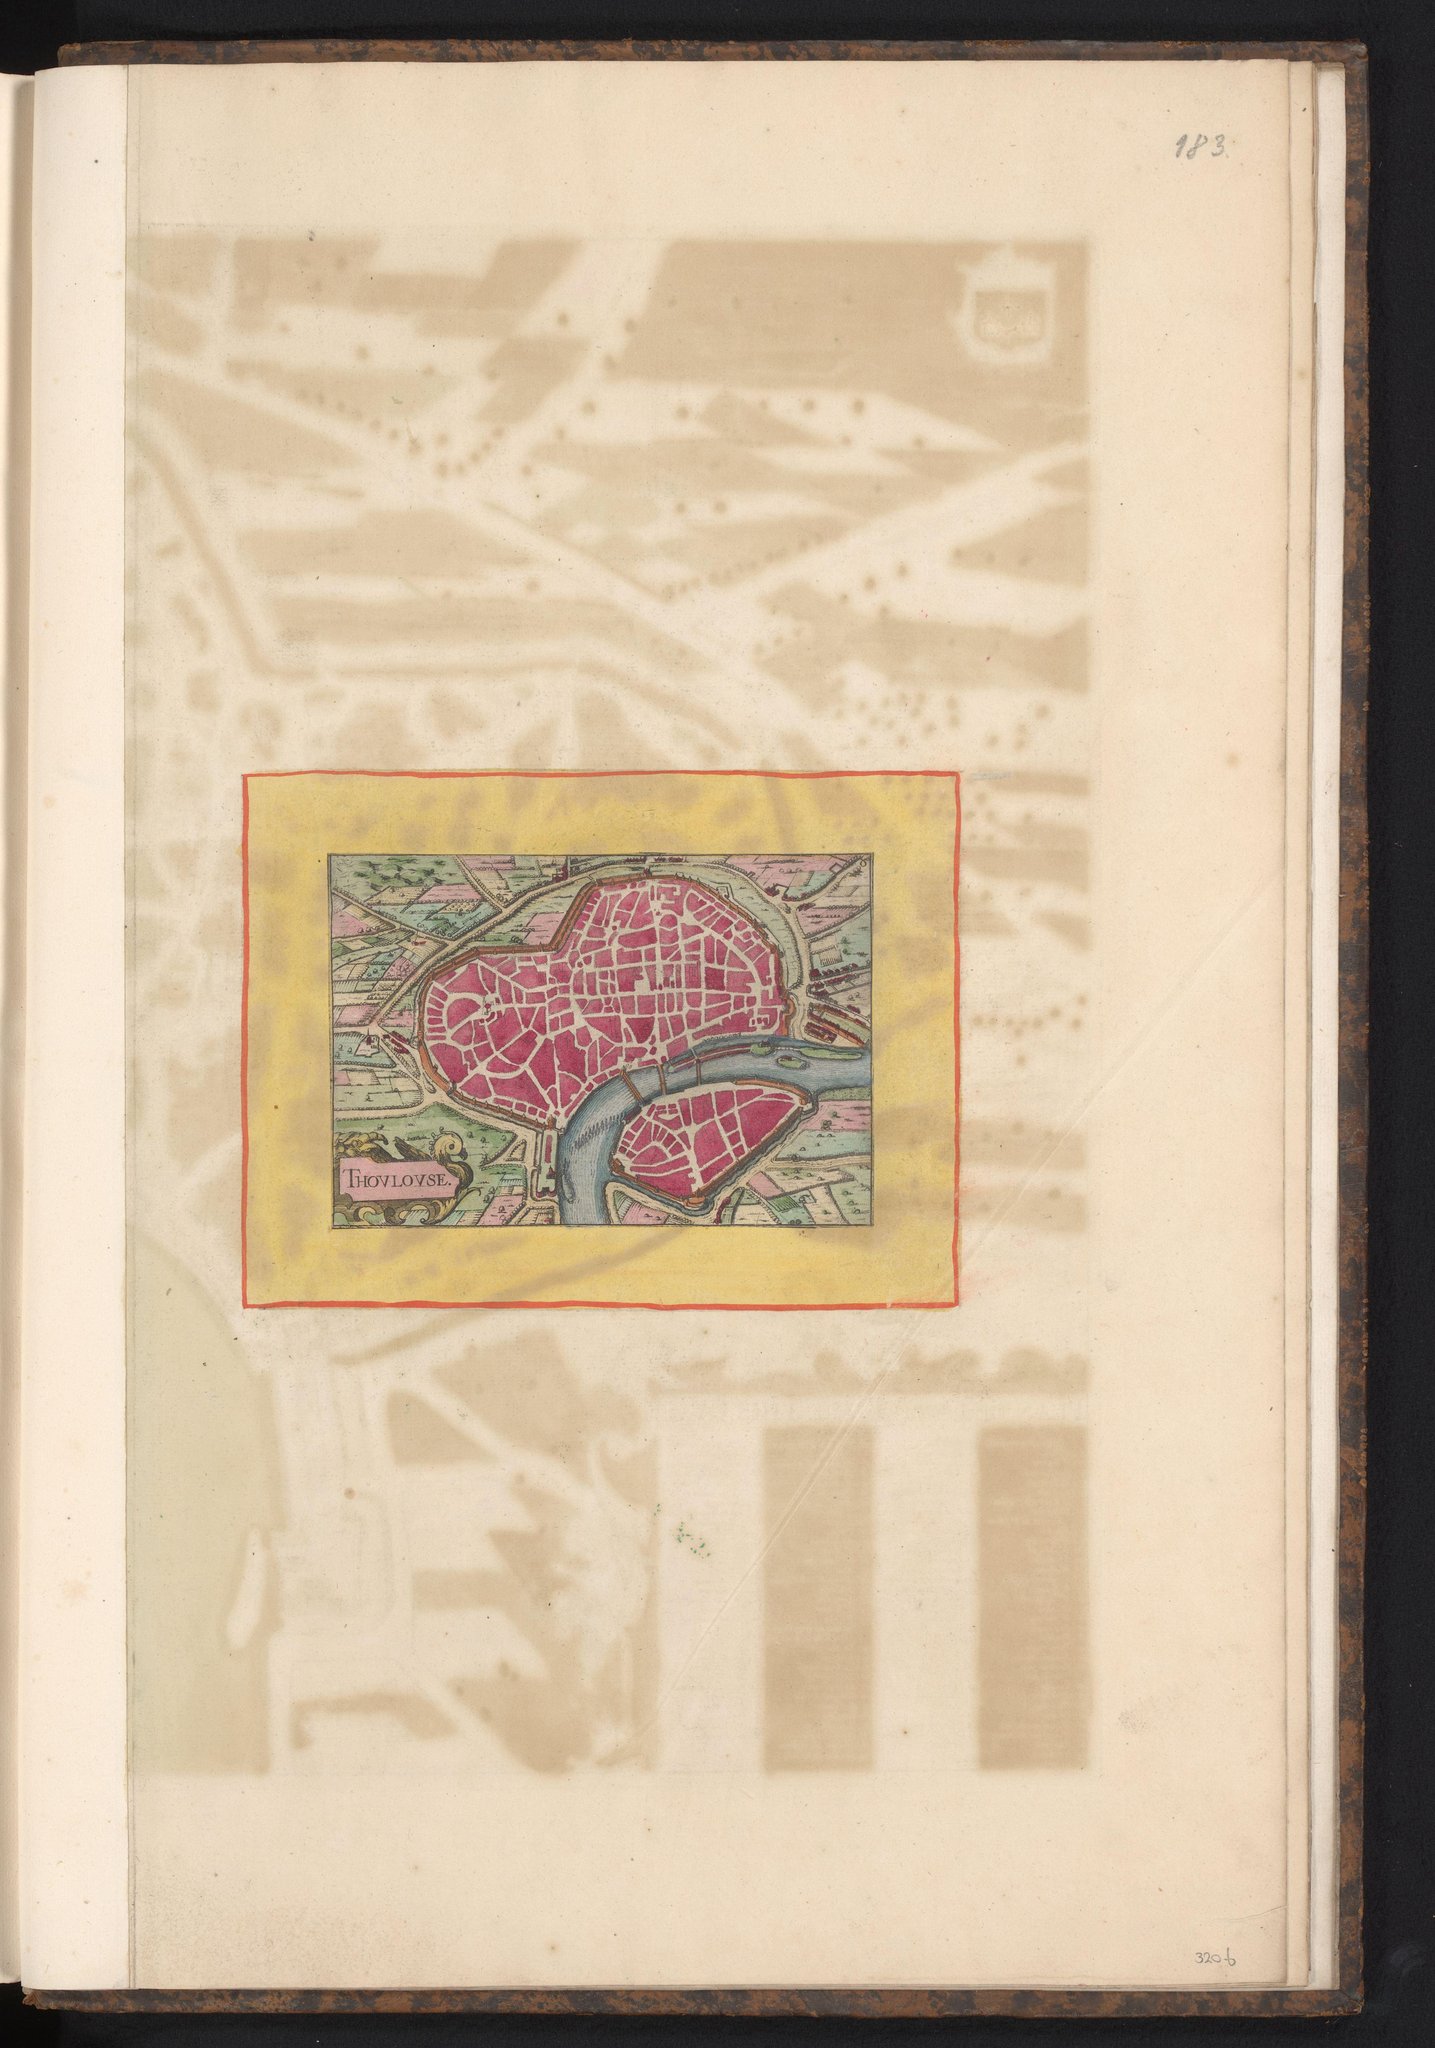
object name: print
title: Plattegrond van Toulouse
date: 1638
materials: paper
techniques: engraving, etching, hand coloring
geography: paris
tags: maps of cities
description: Prent uit: Tassin, Christophe. Les plans et profils de toutes les principales villes et lieux considérables de France (...). Parijs: Michel van Lochom, 1638, kaart 6 uit het deel 'Languedoc'.